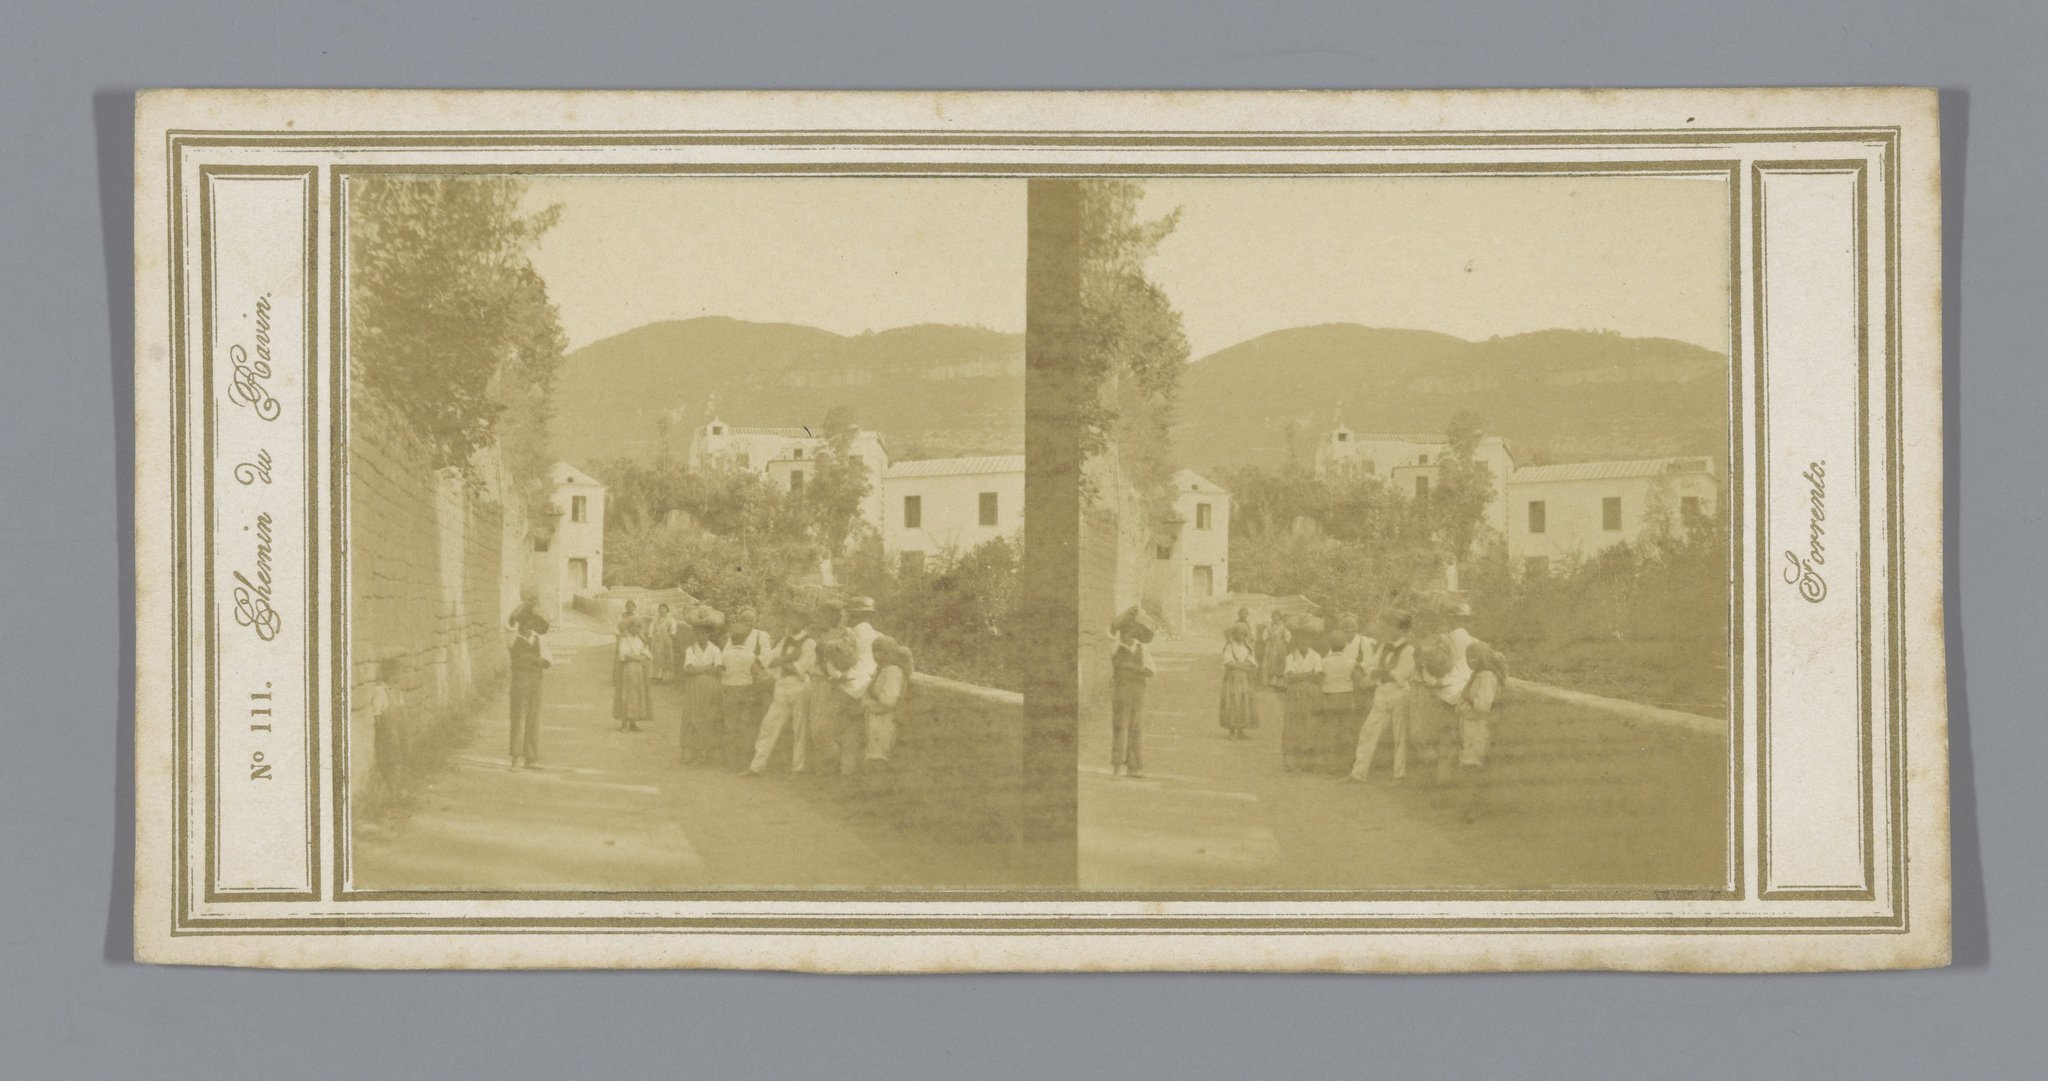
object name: stereograph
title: Gezicht op een weg te Sorrento, met op de voorgrond een groep mensen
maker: Anonymous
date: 1850-1880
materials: cardboard, photographic support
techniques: albumen print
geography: sorrento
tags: public road in village, sorrento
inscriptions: inscription: ‘W: K: W: M:’, number: ‘No 111.’